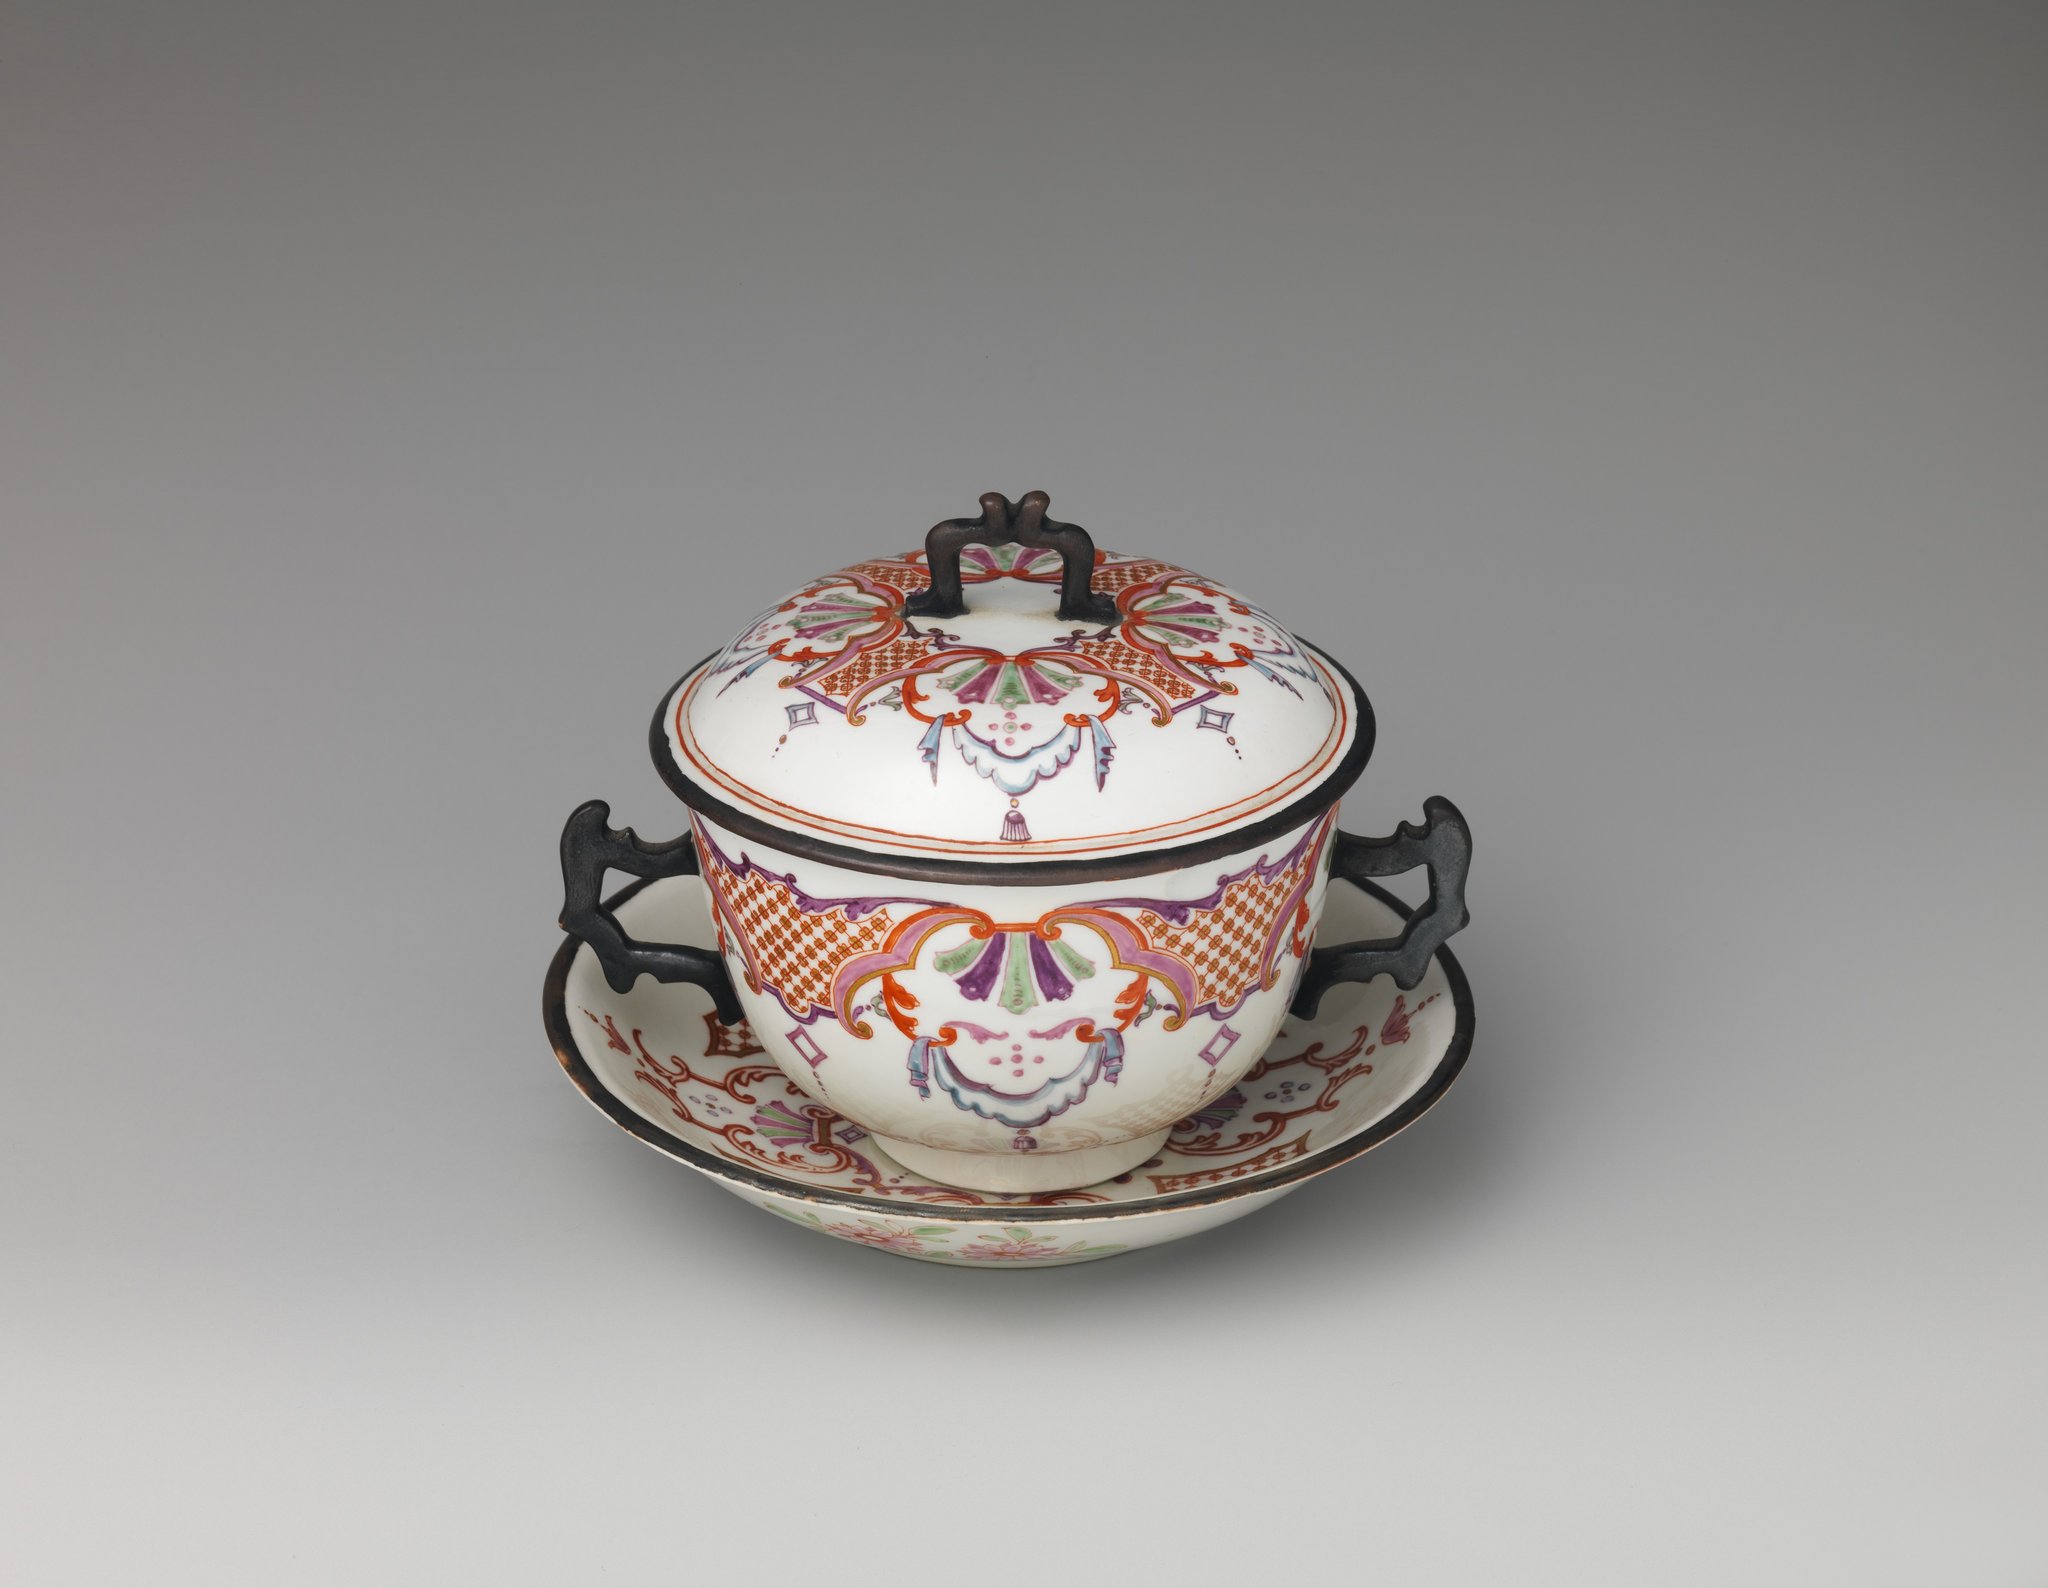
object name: cup with cover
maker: vienna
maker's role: manufactory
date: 1730-1735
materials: hard paste porcelain